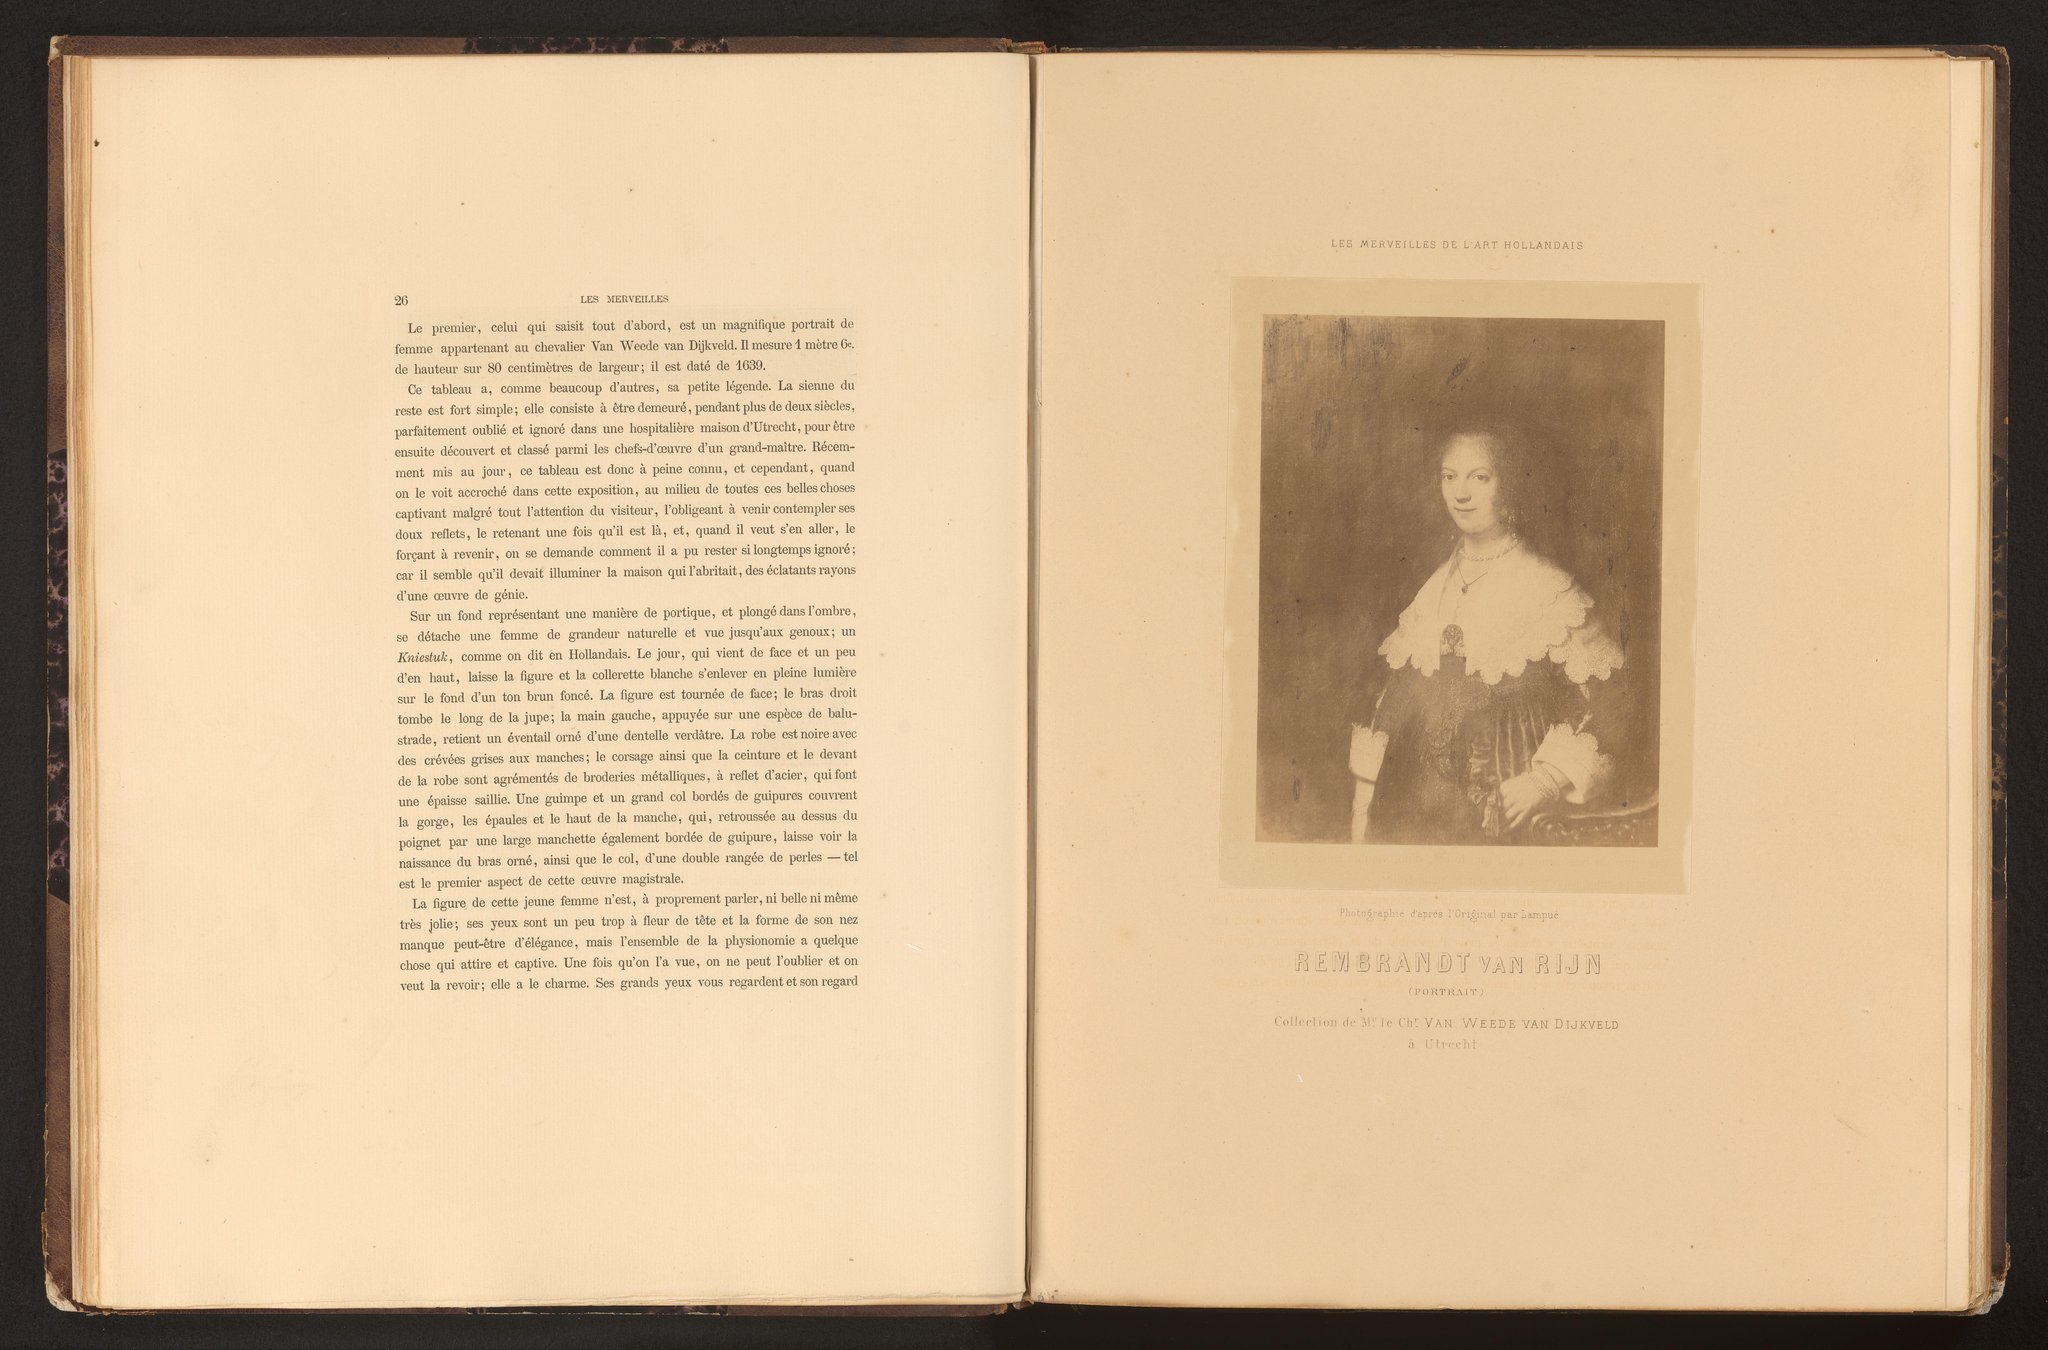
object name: page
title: Fotoreproductie van het geschilderde portret van mogelijk Maria Trip, door Rembrandt van Rijn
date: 1867-1872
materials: paper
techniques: woodburytype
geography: utrecht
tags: historical persons - bb - woman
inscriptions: inscription: ‘Collection de Mr Chr VAN WEEDE VAN DIJKVELD/ á Utrecht’